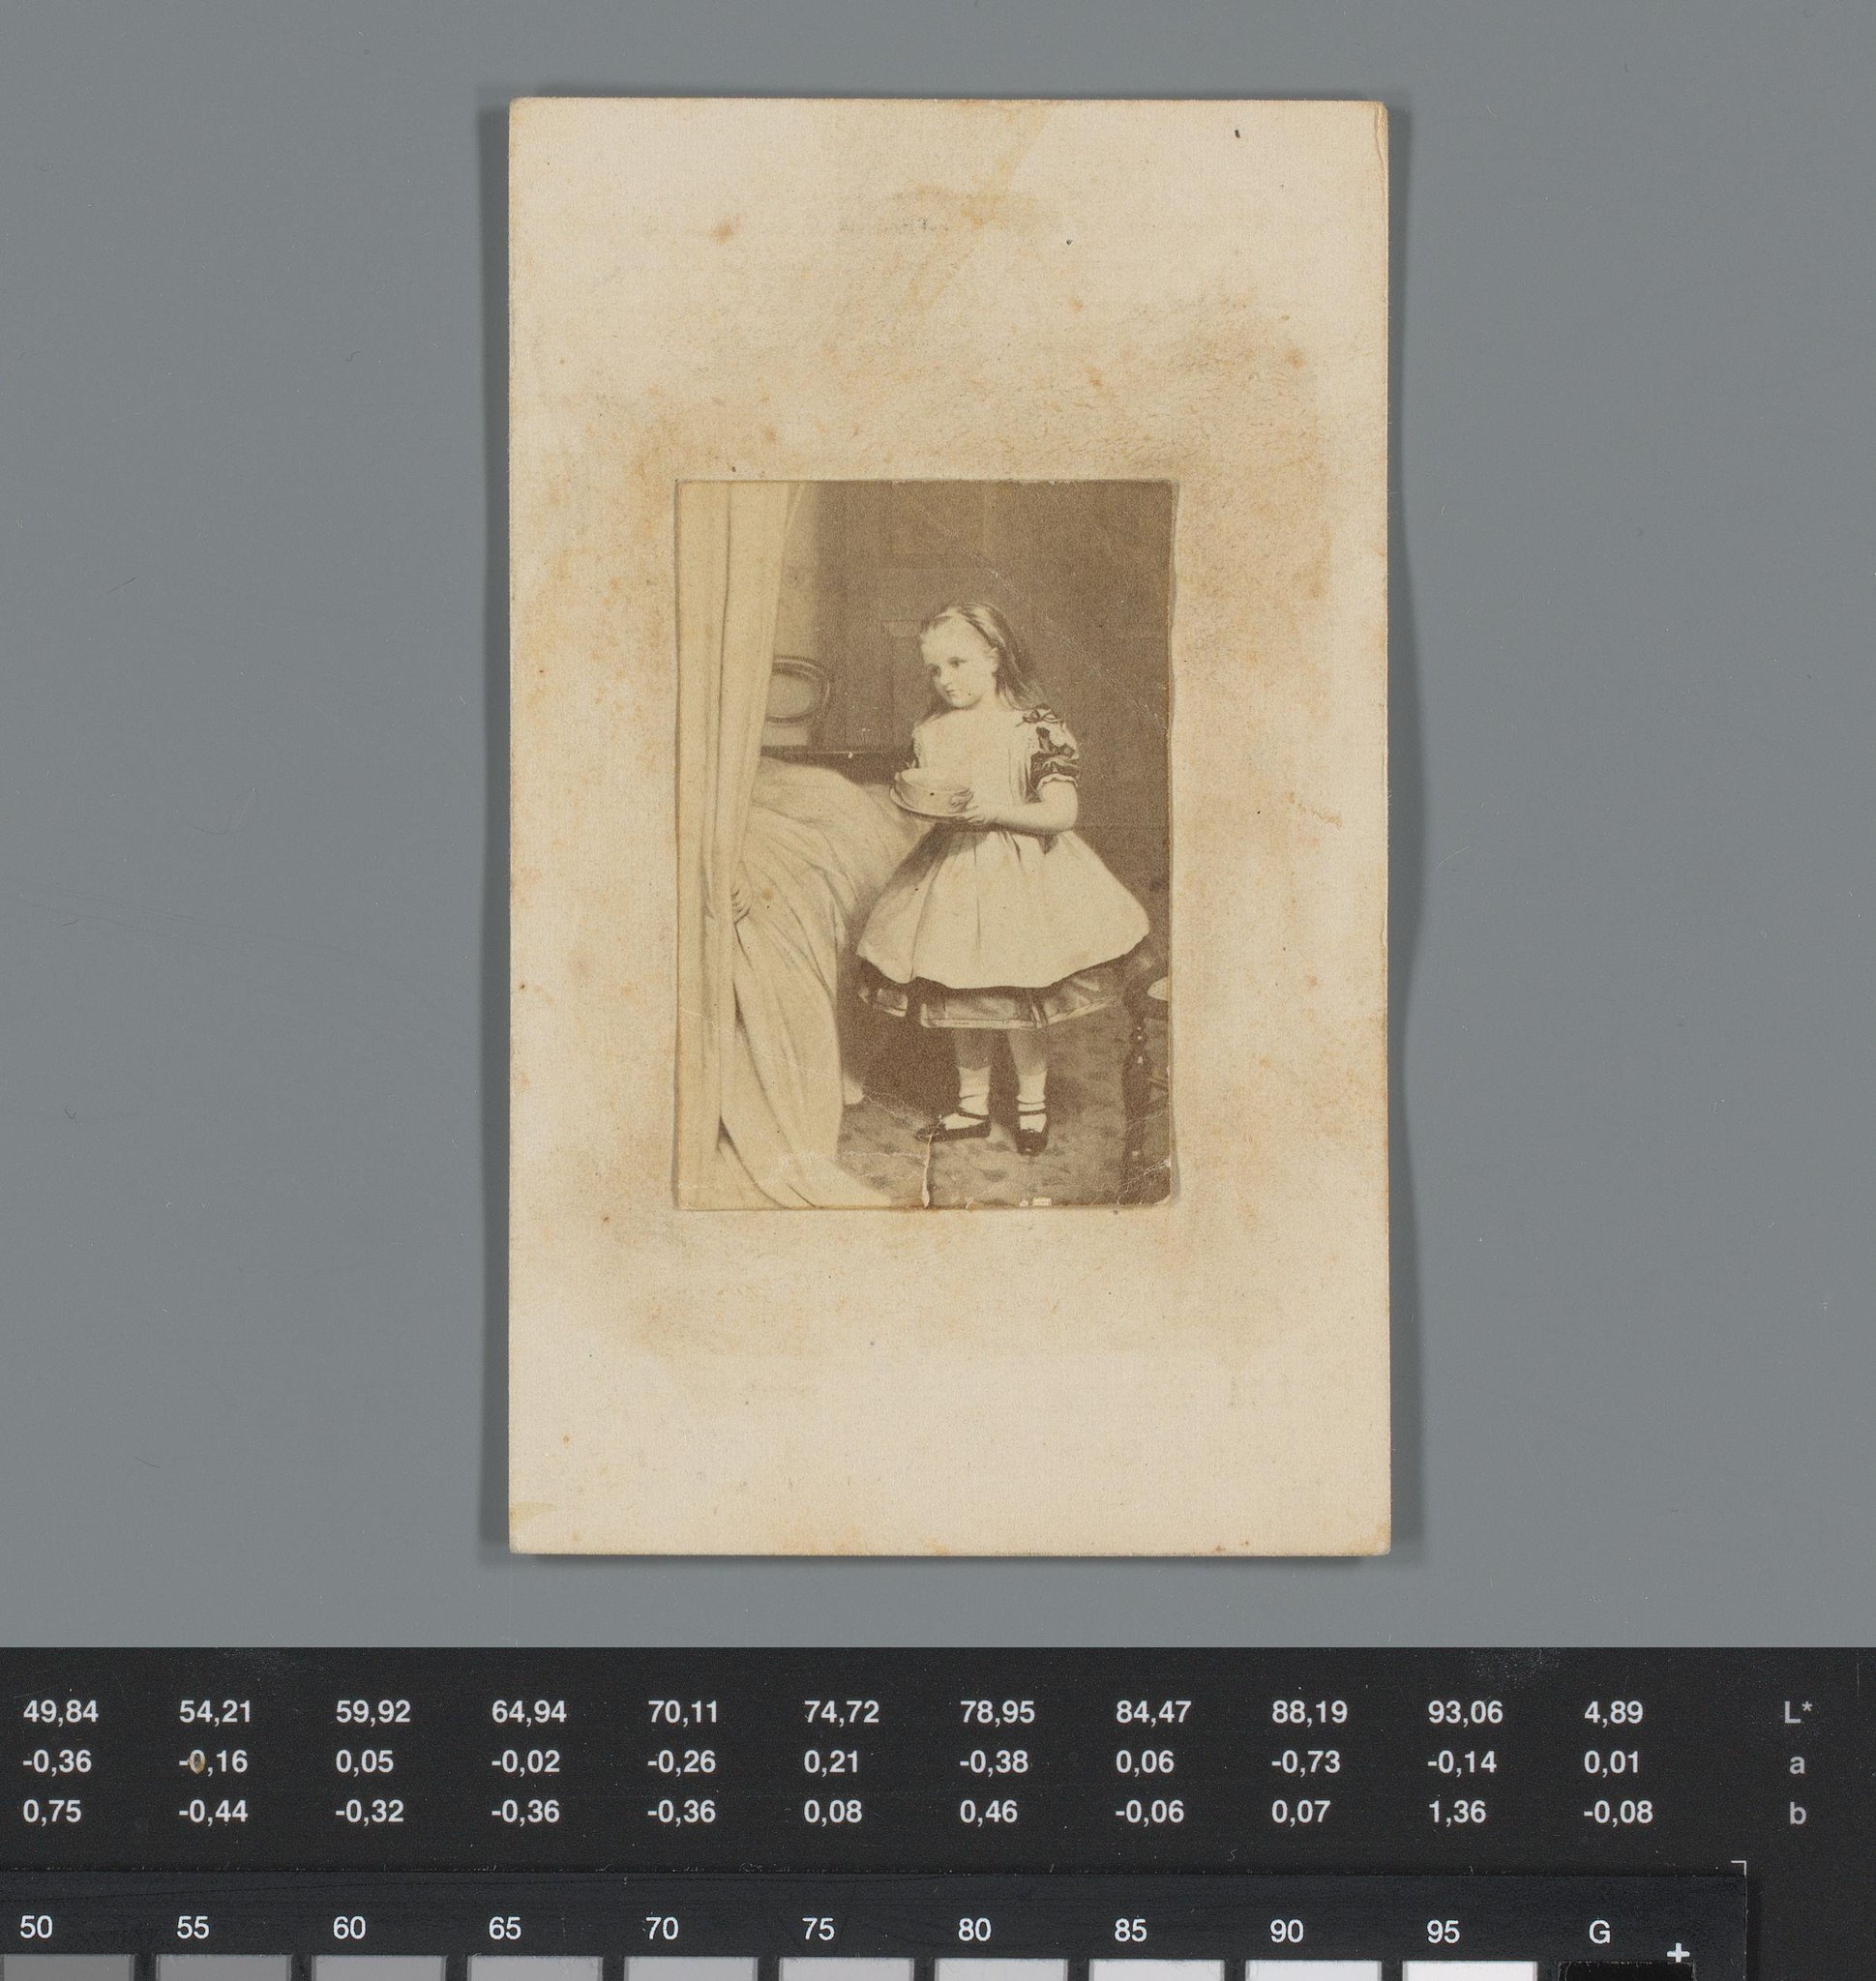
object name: photograph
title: Reclame voor schoenen en hoeden van George J. Tillotson te Emporia met gezicht op een onbekend kind met kom naast een bed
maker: Anonymous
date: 1850-1915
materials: cardboard, photographic support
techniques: albumen print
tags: advertising, girl (child between toddler and youth)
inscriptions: inscription: ‘Geo. J. TILLOTSON, / BOOTS AND SHOES, / HATS & CAPS, / SIGN / GOLDEN SHOE (...) EMPORIA, KANSAS.’